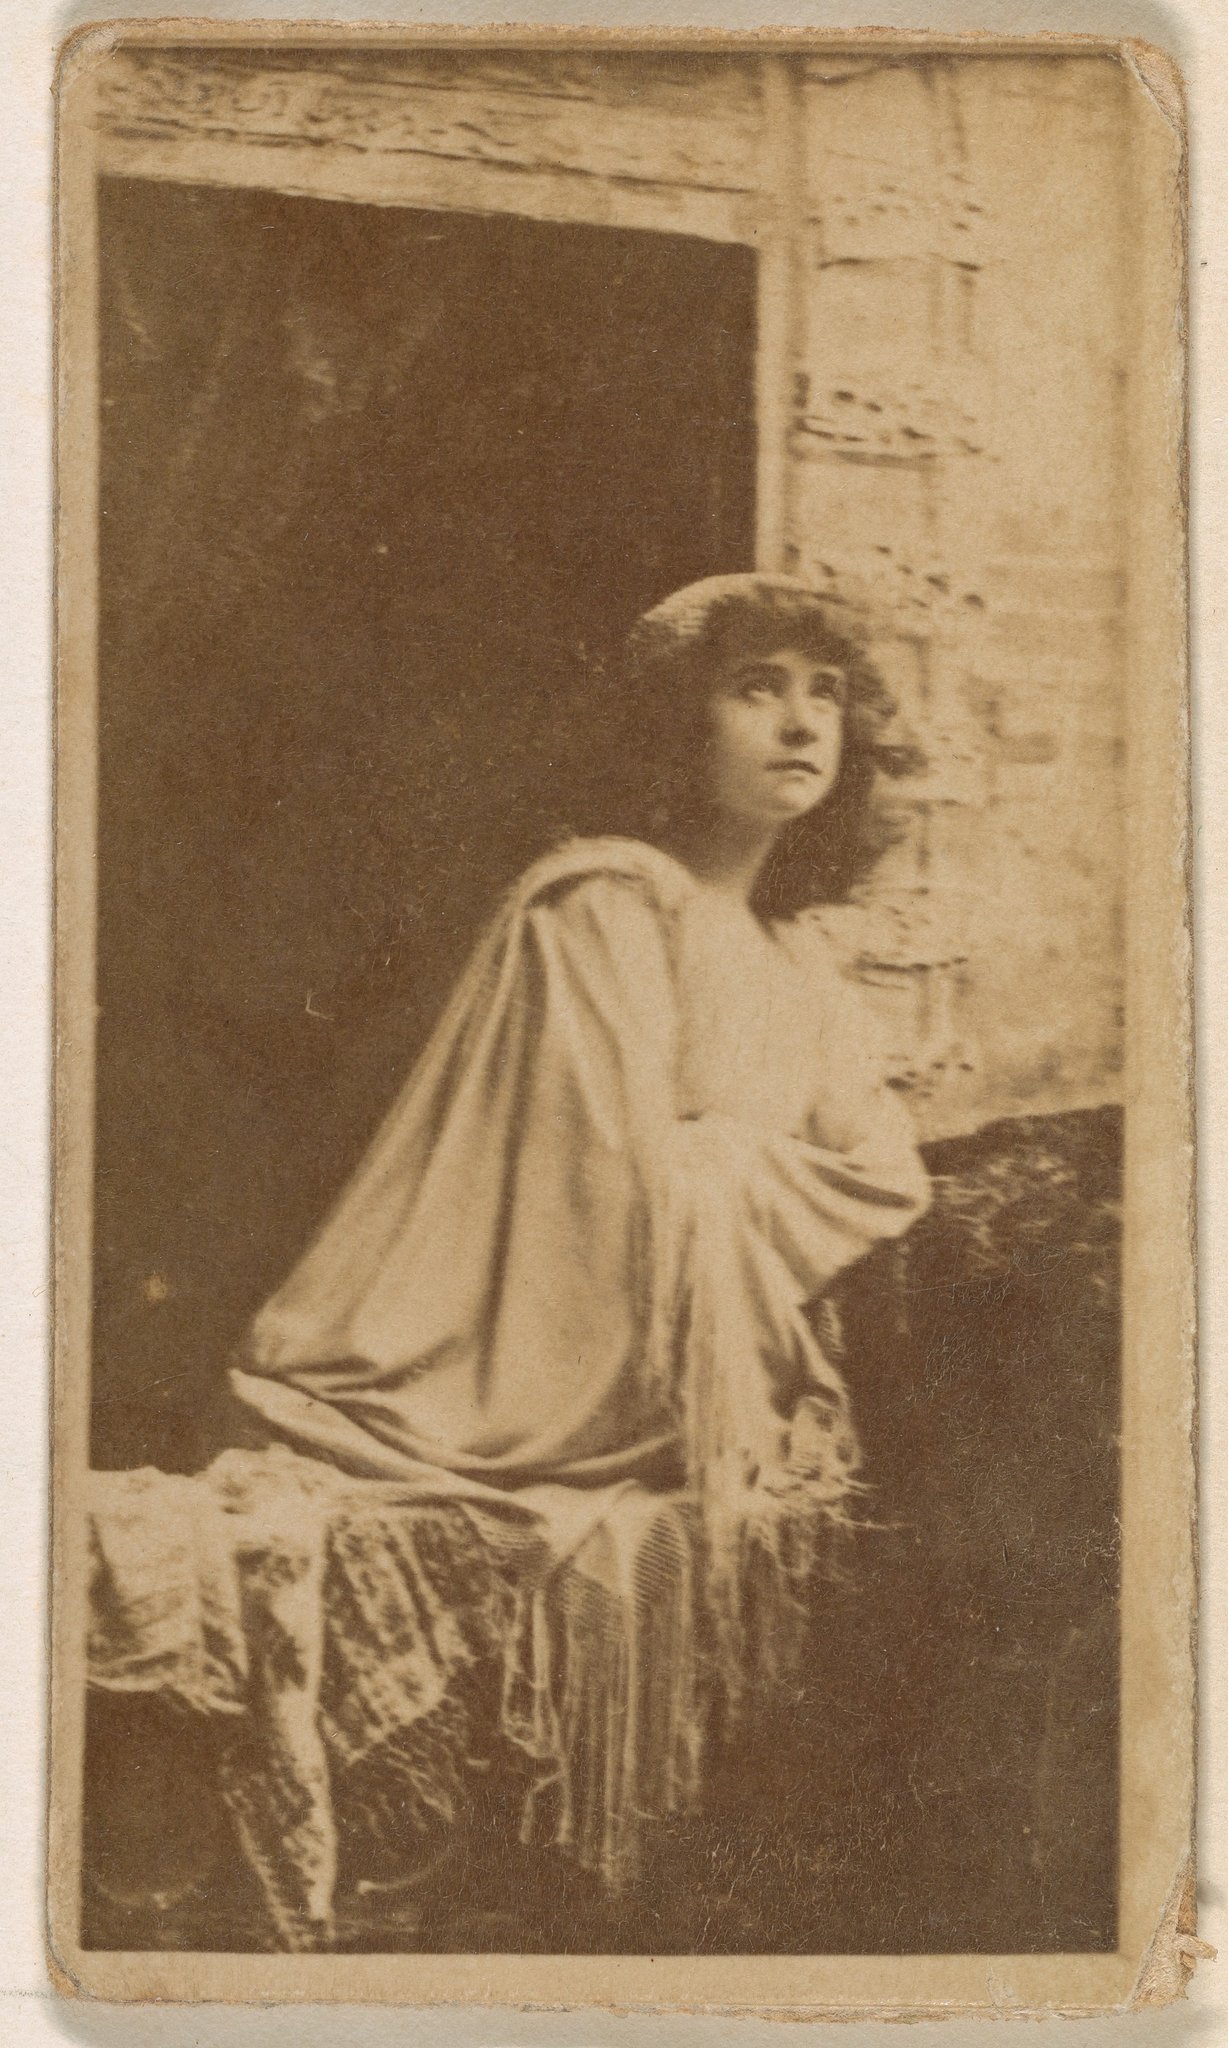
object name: photograph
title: Actress posed in open window, from the Actresses series (N245) issued by Kinney Brothers to promote Sweet Caporal Cigarettes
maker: kinney brothers tobacco company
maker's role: publisher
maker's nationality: american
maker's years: 1869-2011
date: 1890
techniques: albumen silver print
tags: portraits,women,actresses